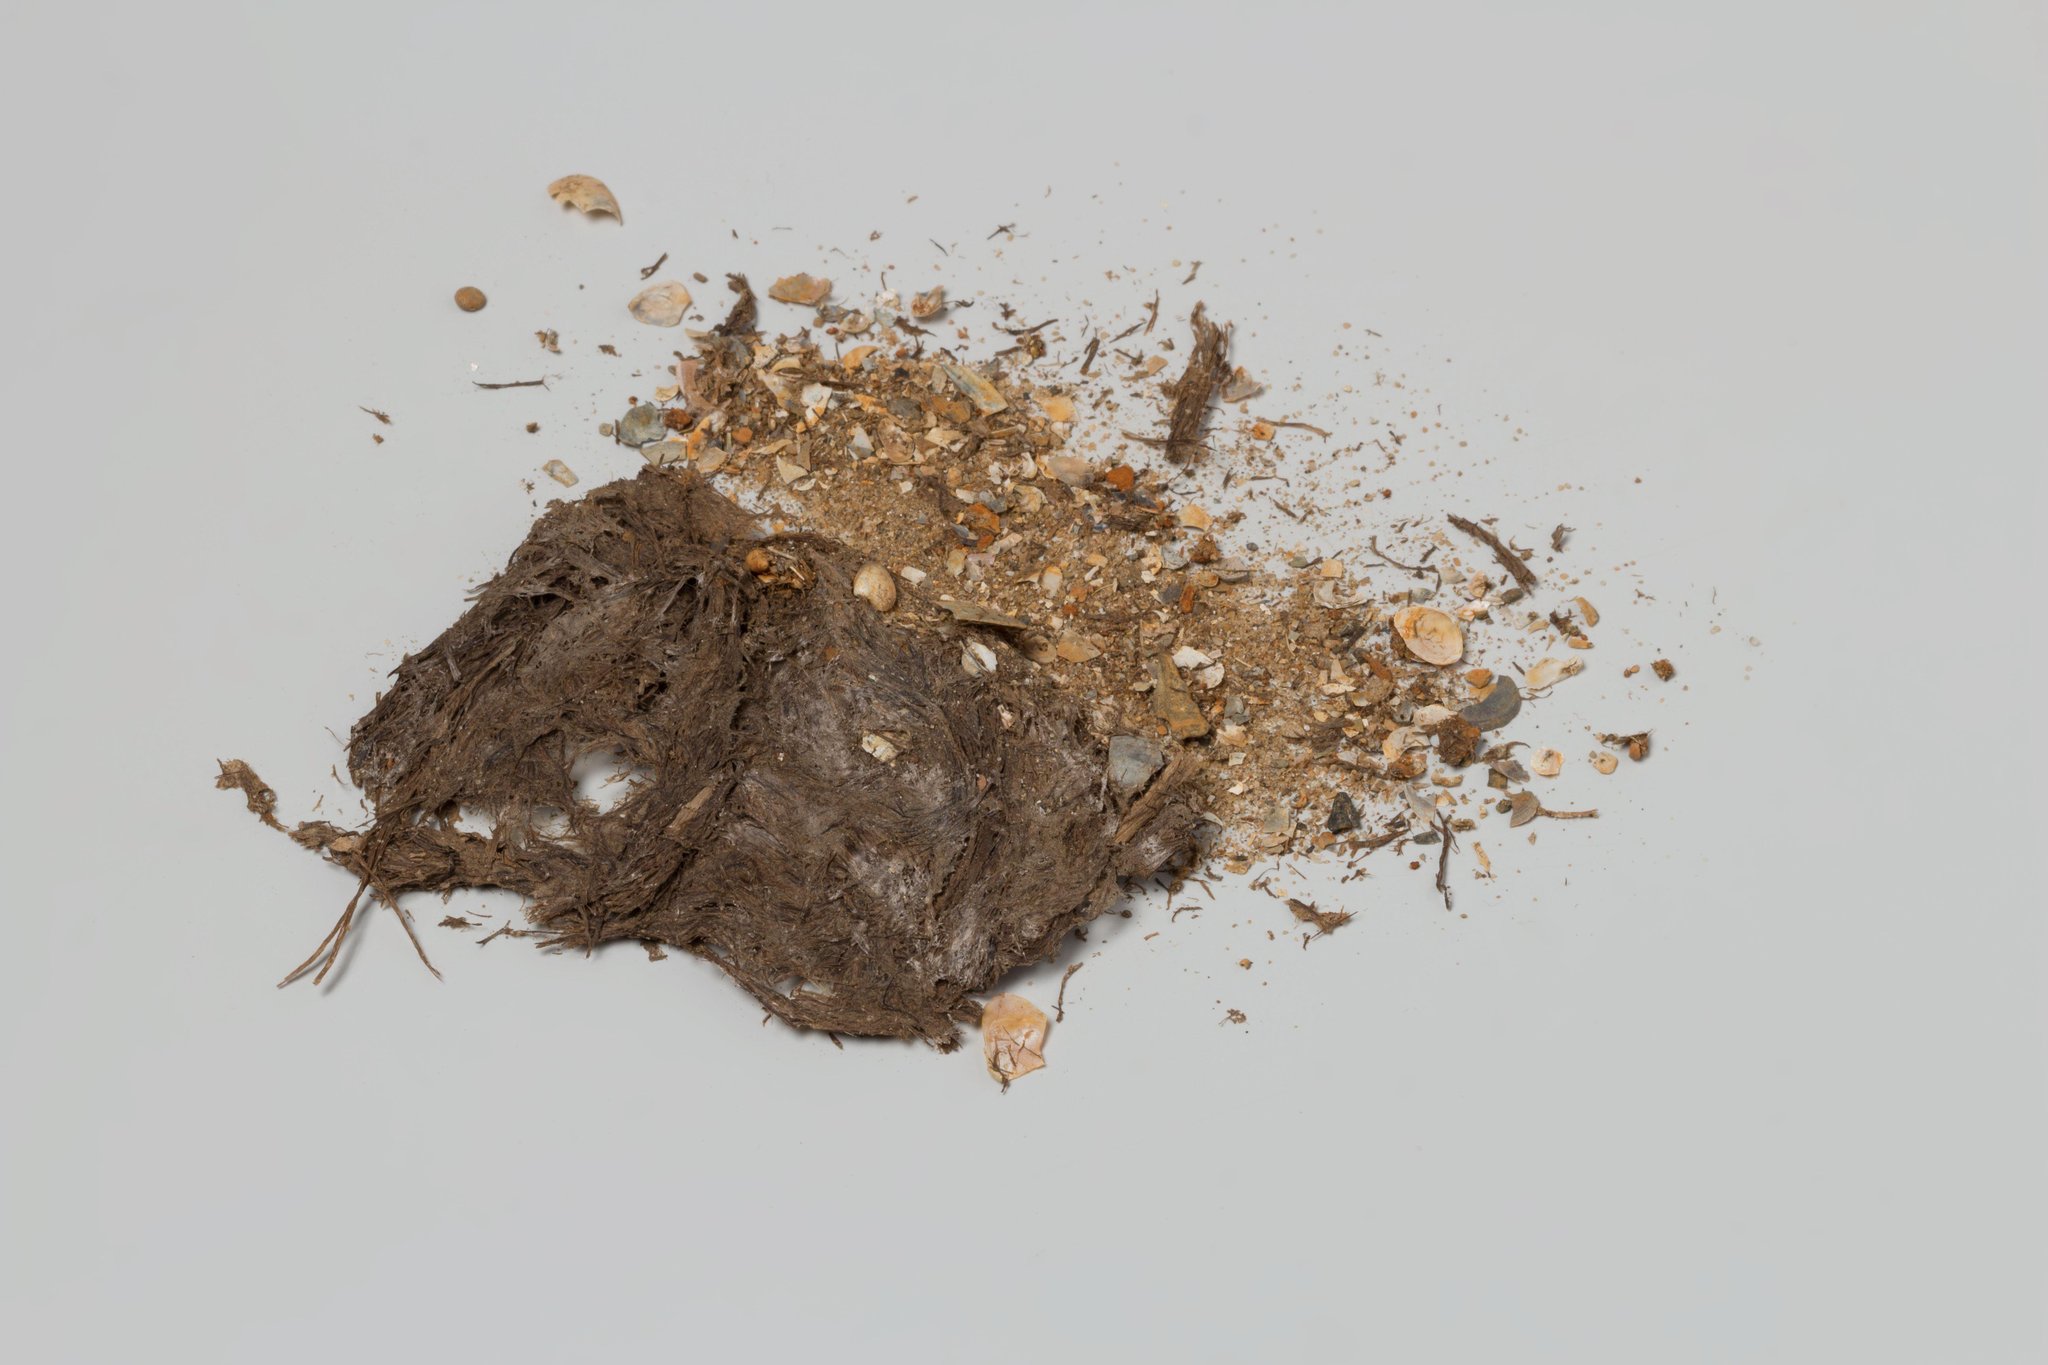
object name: rope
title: Fragment van een touw of geweven stuk textiel uit het wrak van de in 1735 vergande Oost-Indiëvaarder 't Vliegend Hart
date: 1700-1735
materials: hemp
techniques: ropemaking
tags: 't vliegend hart (schip), verenigde oostindische compagnie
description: Het fragment is bijna vierkant en plat. Het is een rommelig stuk vezels, bruin van kleur. Rope.